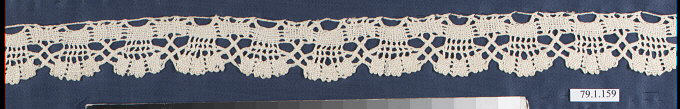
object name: edging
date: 1501-1600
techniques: lace